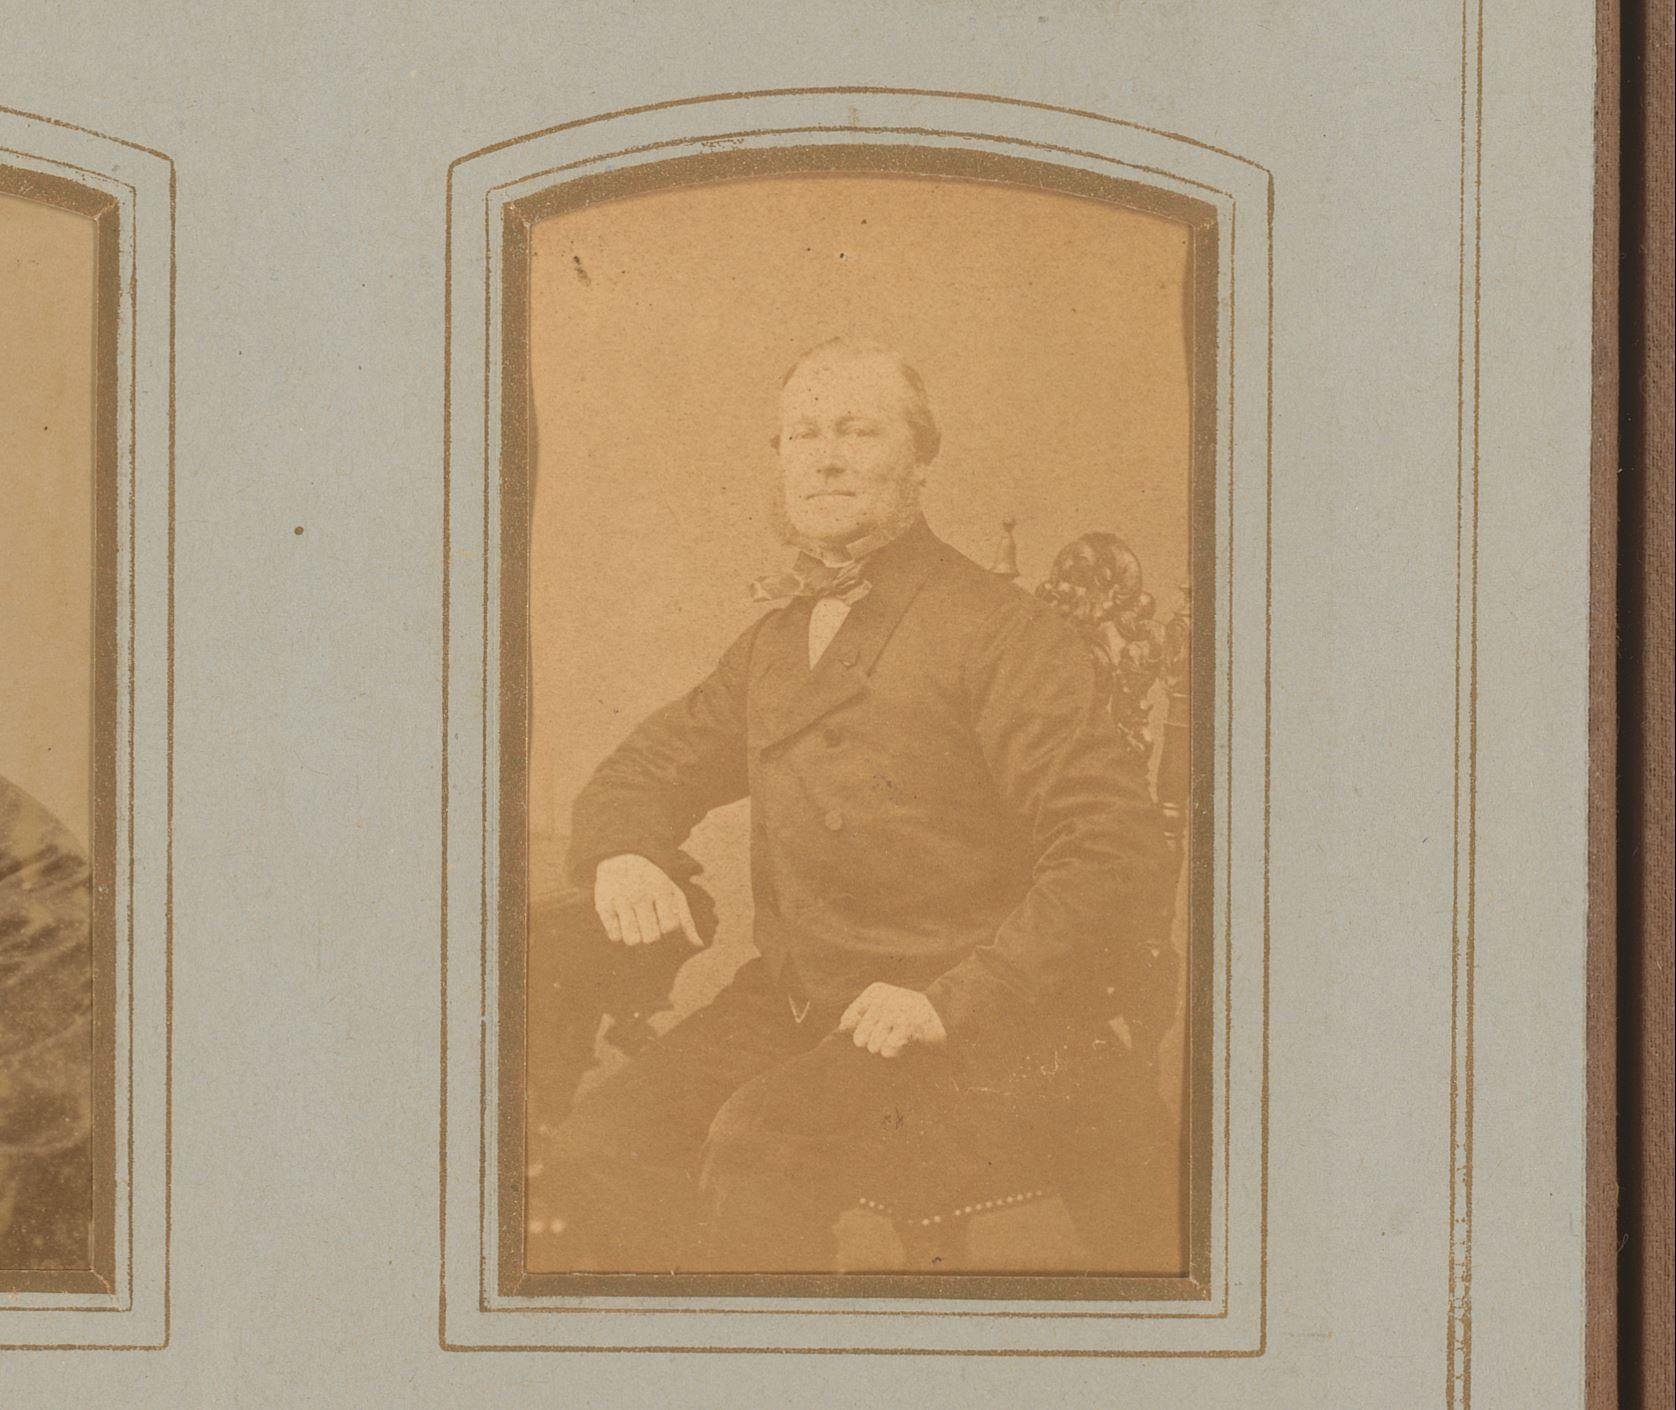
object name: photograph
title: Portret van een man, zittend op een stoel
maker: albert greiner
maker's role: fotograaf, fotostudio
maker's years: 1833-1890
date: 1861-1874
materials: cardboard, photographic support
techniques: albumen print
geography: amsterdam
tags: sitting figure, historical persons, chair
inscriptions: inscription: ‘A. Greiner./ PHOTOGRAF/ NIEUWENDIJK L. 87/ AMSTERDAM.’